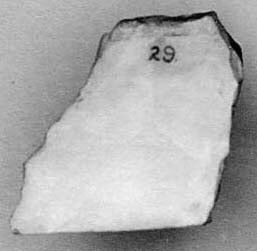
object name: fragment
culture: burmese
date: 1902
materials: jade